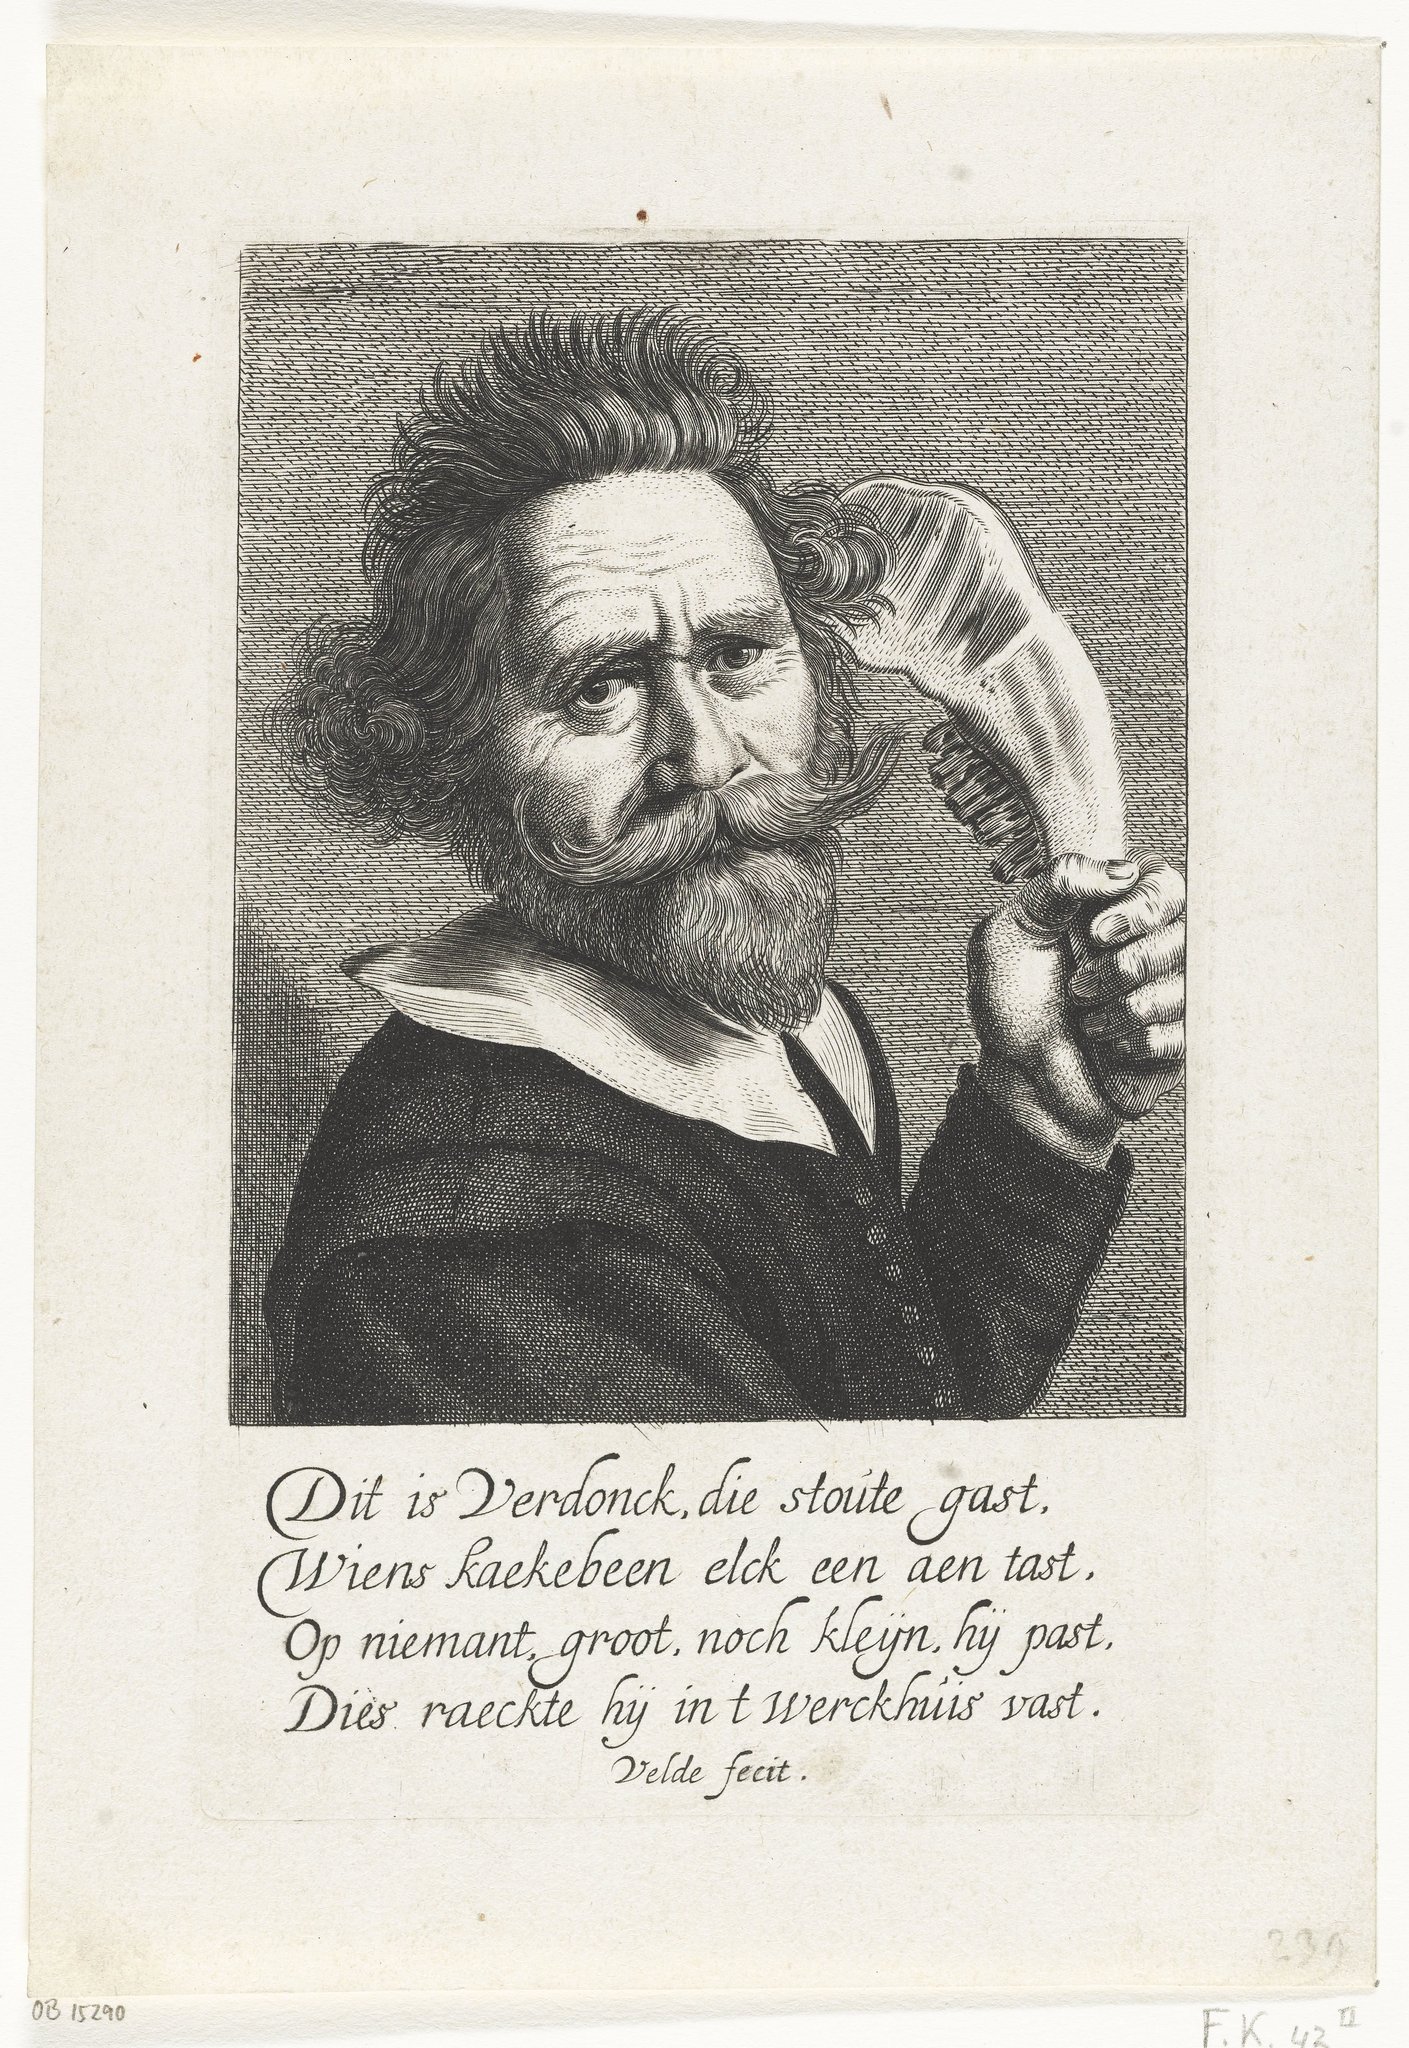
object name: print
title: Portret van Verdonck, met ezelskaak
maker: jan van de velde (ii)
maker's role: draughtsman, painter, print maker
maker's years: 1593-1641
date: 1603-1641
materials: paper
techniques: engraving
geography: northern netherlands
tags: with an ass's jaw-bone samson slays a thousand philistines (+ variant)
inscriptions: signature: ‘Velde fecit’, caption: ‘Dit is verdonck die stoute gast / wiens kaekebeen elck een aen tast / Op niemant groot, noch klein, hij past / Dies reackte hij int werkhuis vast’, collector's mark: Lugt 240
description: Portret van een onbekende wildebras met de naam Verdonck, met ezelskaak in de linkerhand. Met vier regels Nederlands onderschrift, waarin wordt verteld dat hij in het Werkhuis is beland.